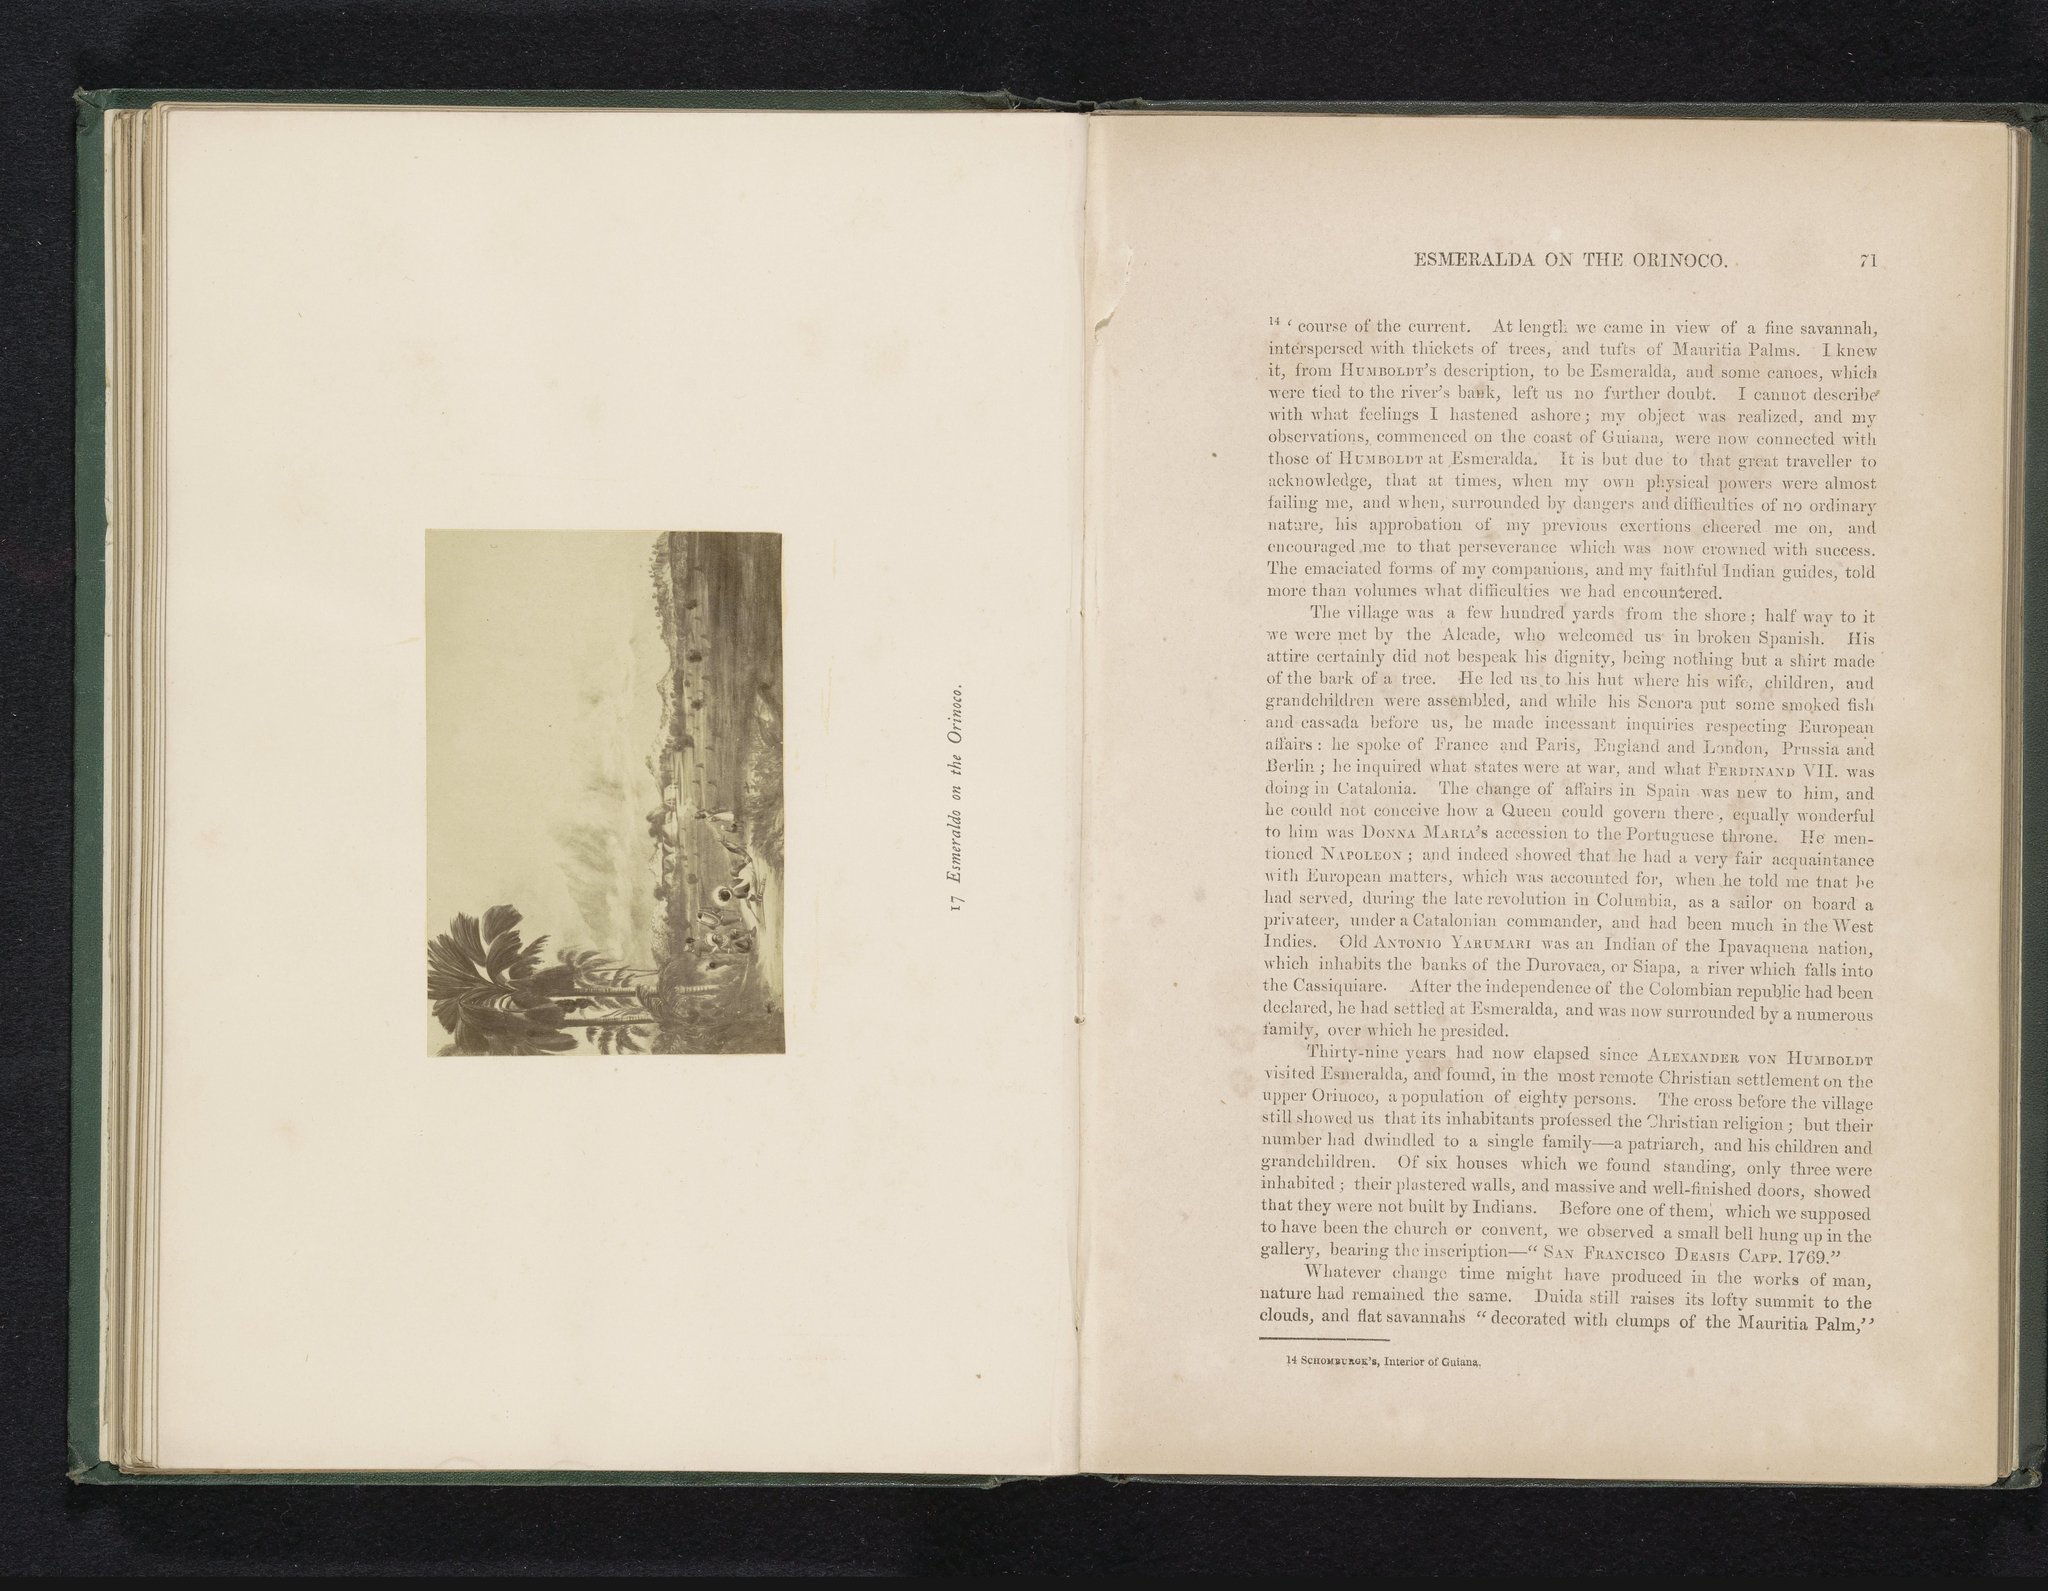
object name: photograph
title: Fotoreproductie van een tekening van La Esmeralda aan de Orinoco-rivier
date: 1856-1866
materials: photographic support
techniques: albumen print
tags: trees: palm-tree, prospect of city, town panorama, silhouette of city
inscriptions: number: ‘17’